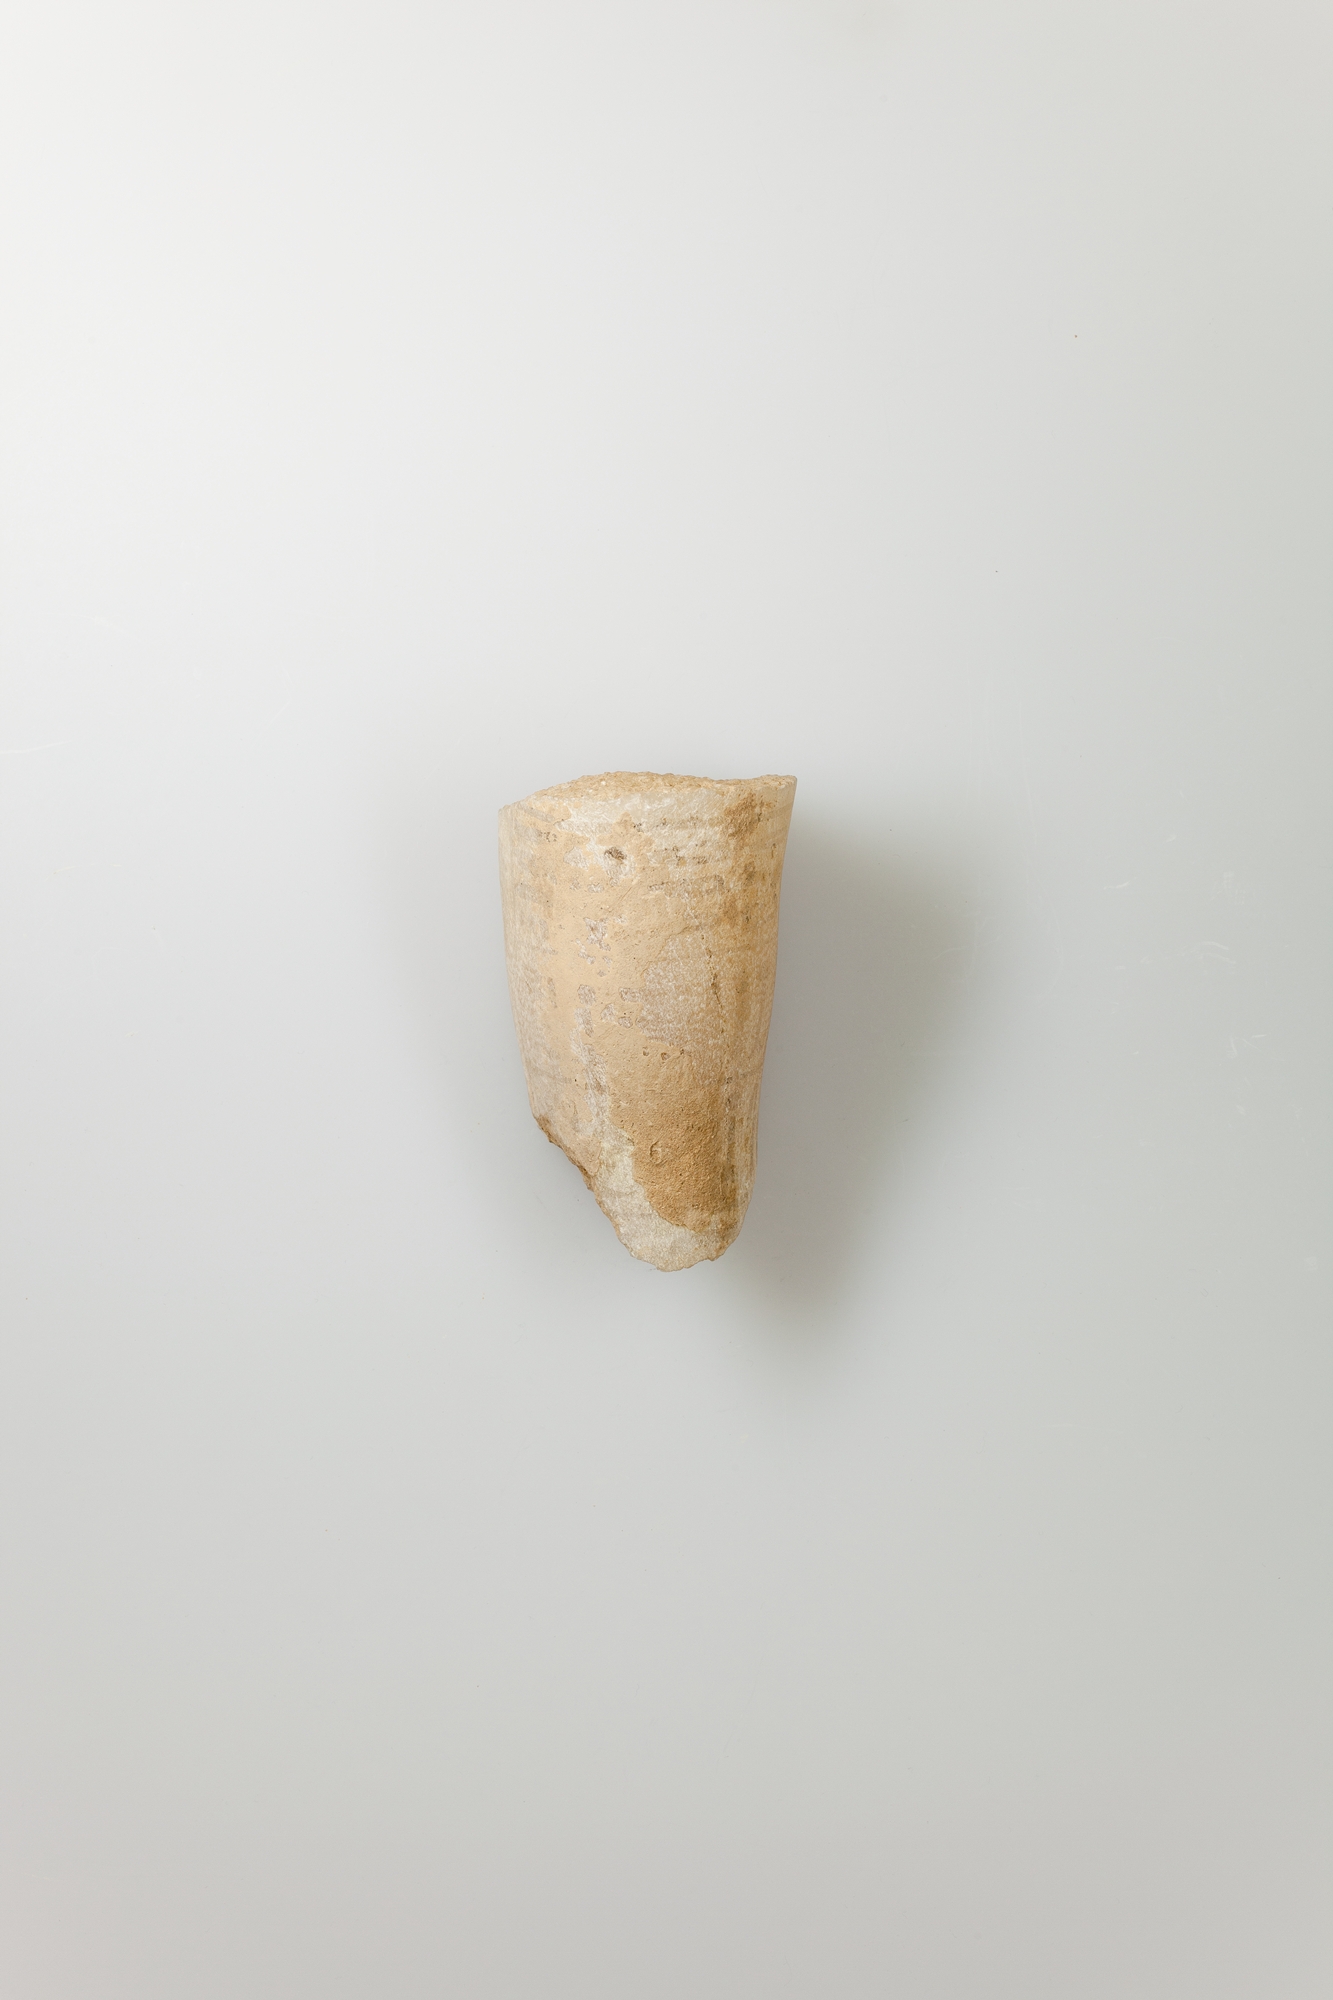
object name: shabti, siptah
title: Shabti of Siptah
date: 1194-1188 BCE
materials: stone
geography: egypt